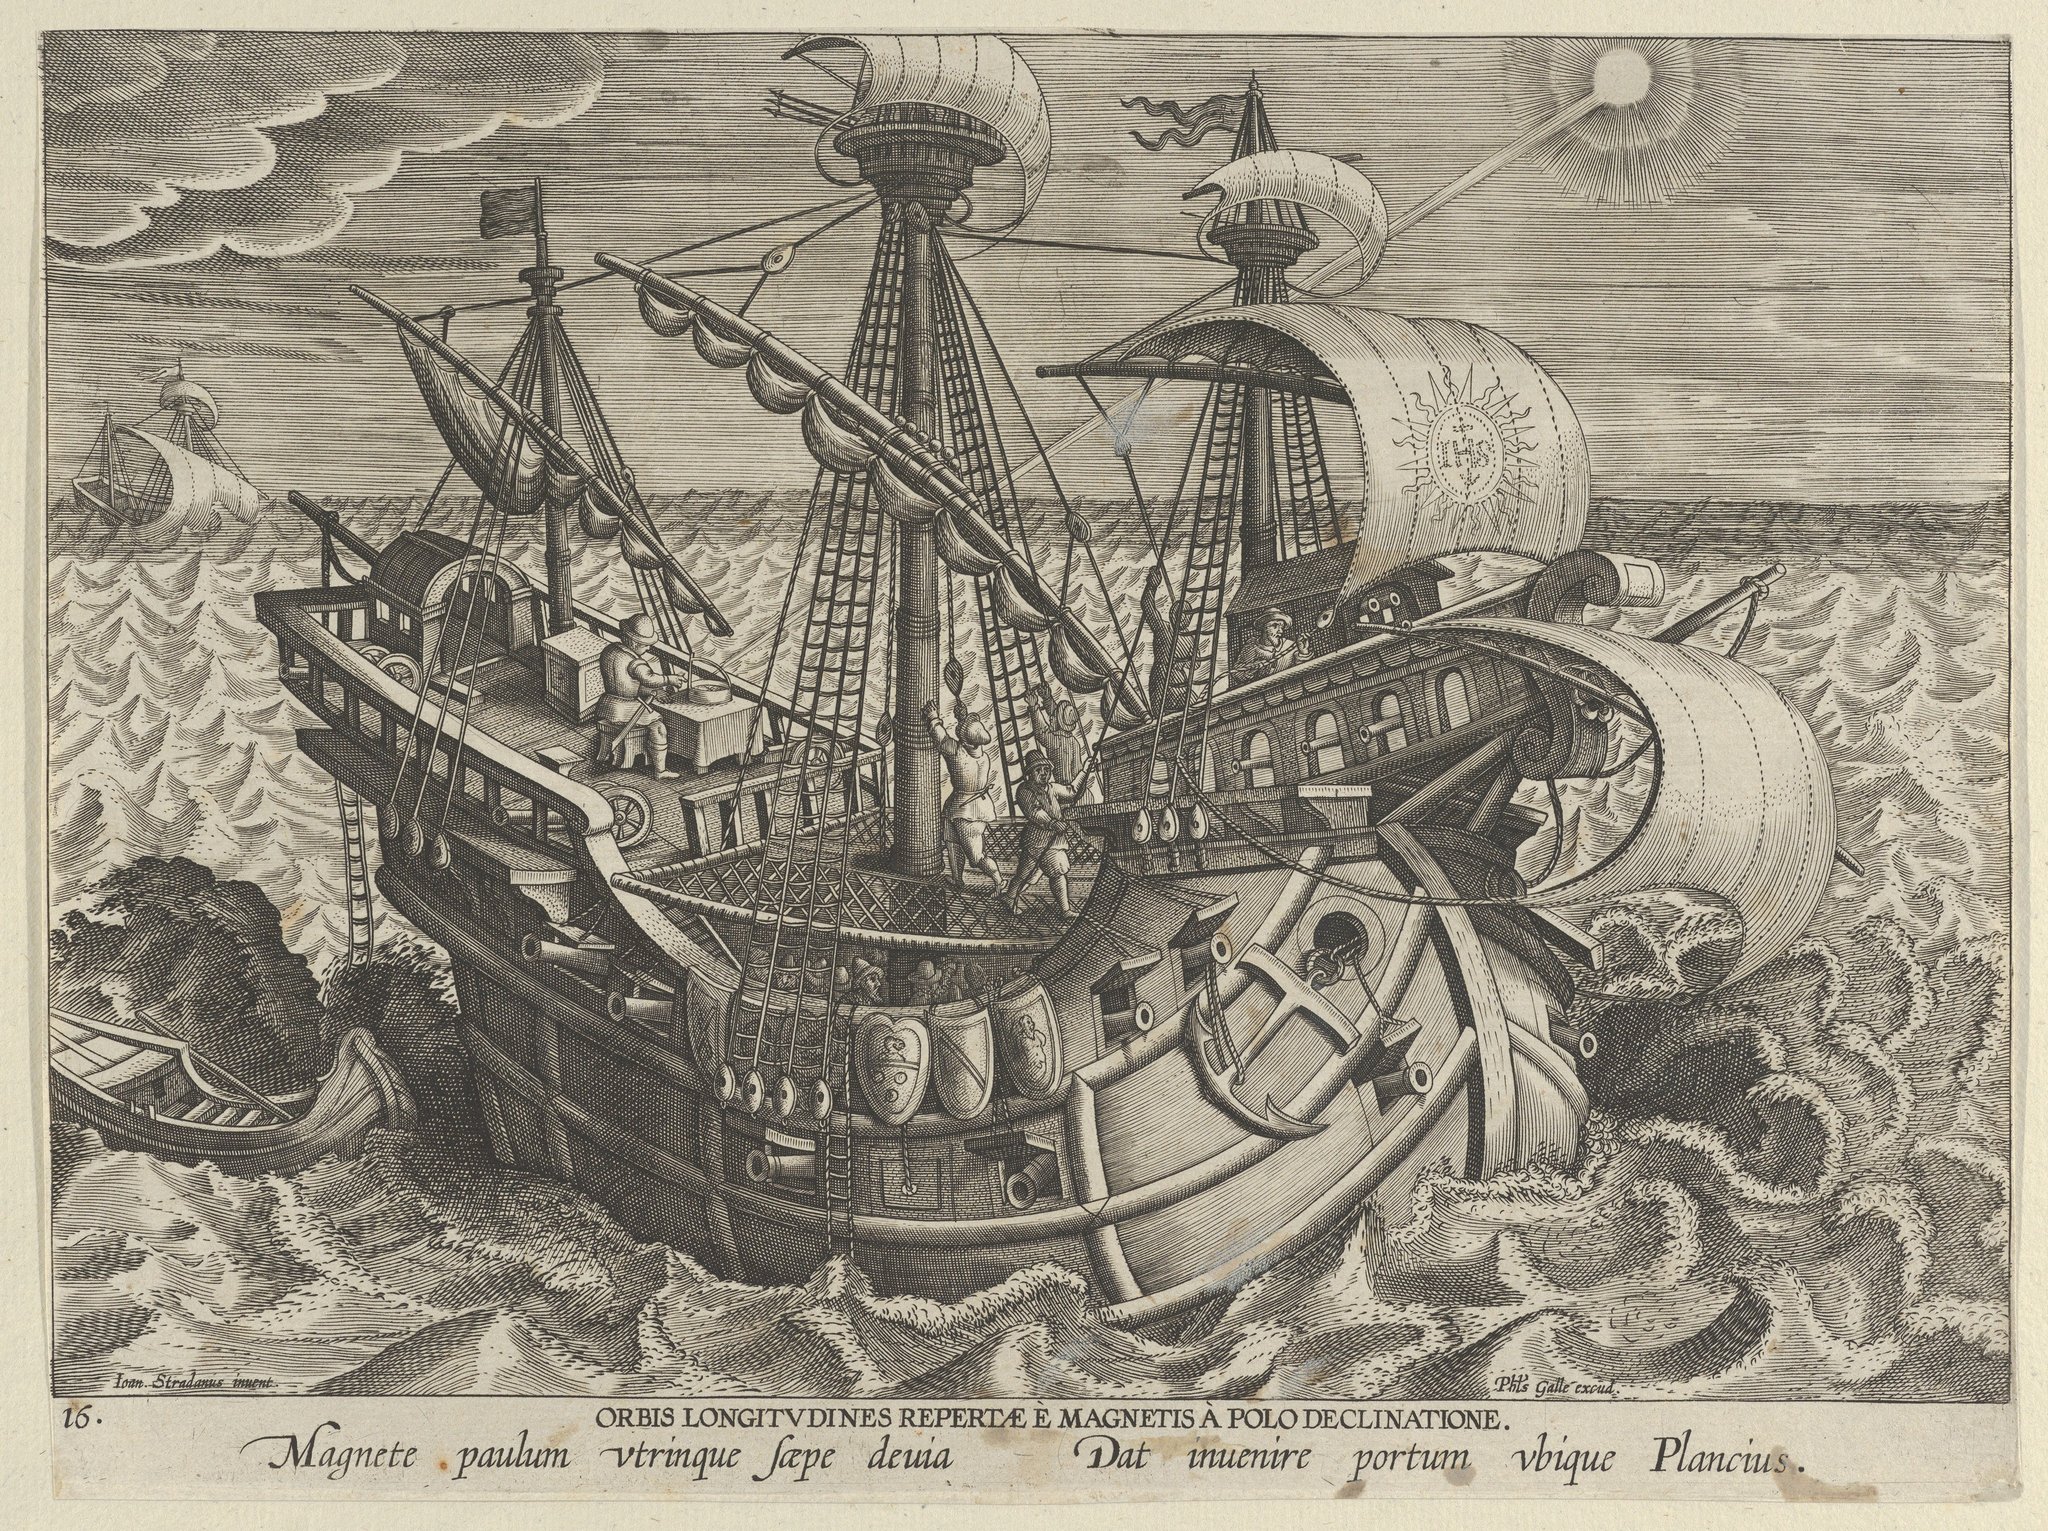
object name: print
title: New Inventions of Modern Times [Nova Reperta], The Discovery of the Establishment of the Longitudes, plate 16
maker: jan collaert i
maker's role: artist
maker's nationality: netherlandish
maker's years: 1530-1581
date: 1600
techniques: engraving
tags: ships